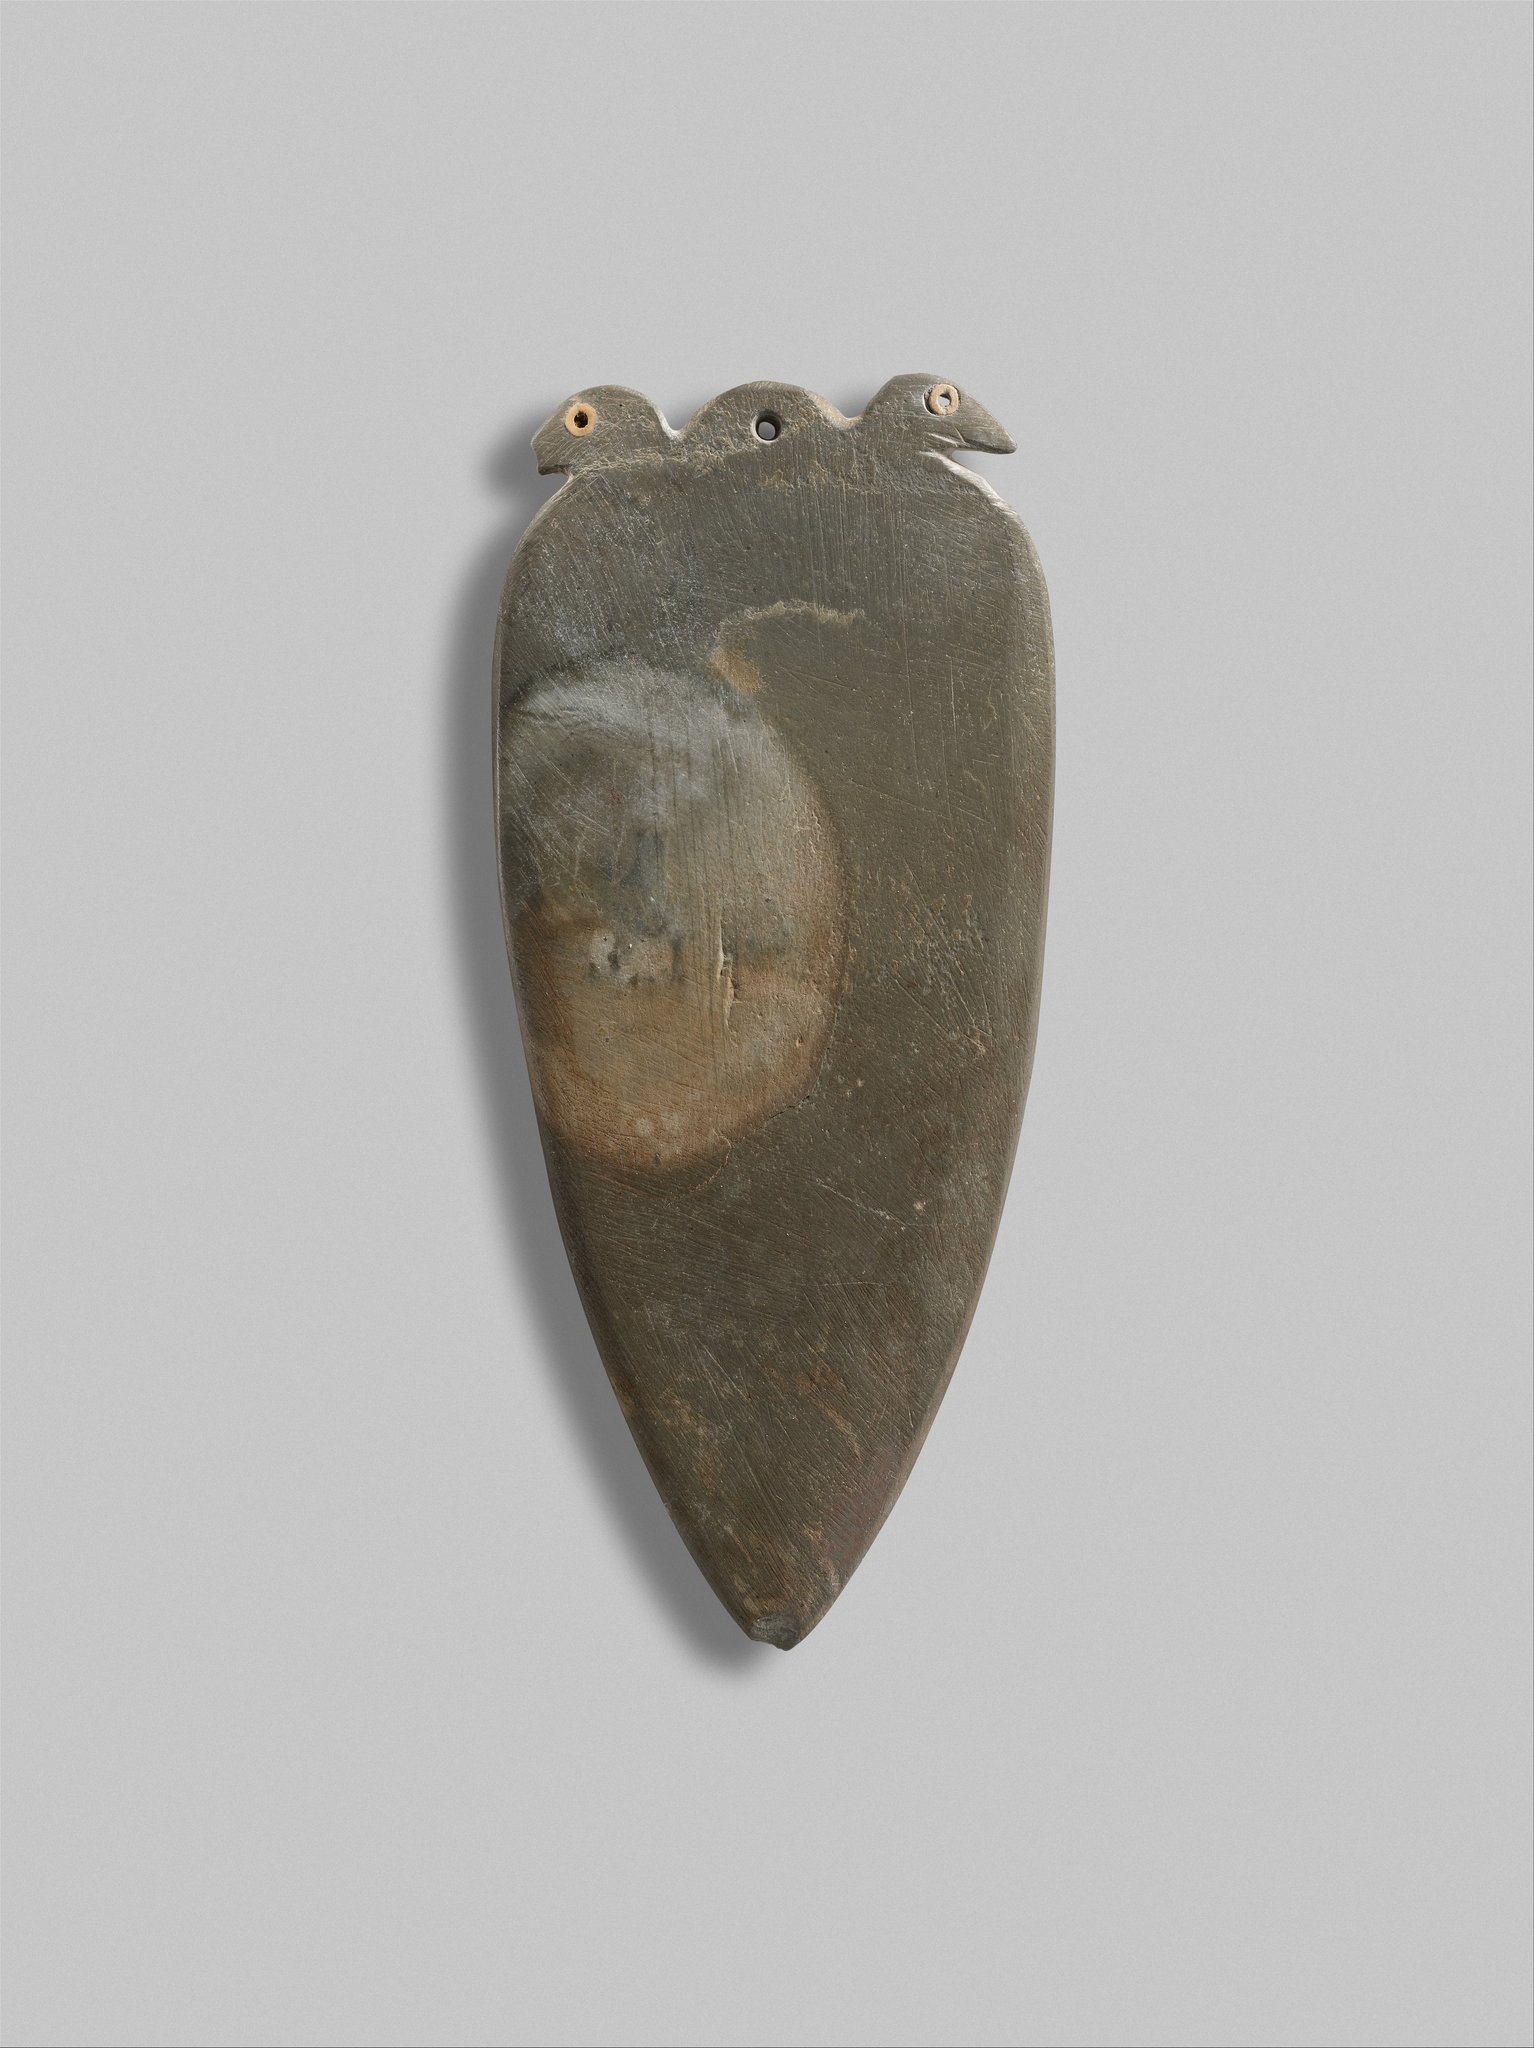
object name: palette, double bird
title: Palette with double bird heads with inlaid eyes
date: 3500-3300 BCE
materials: shell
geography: egypt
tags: birds